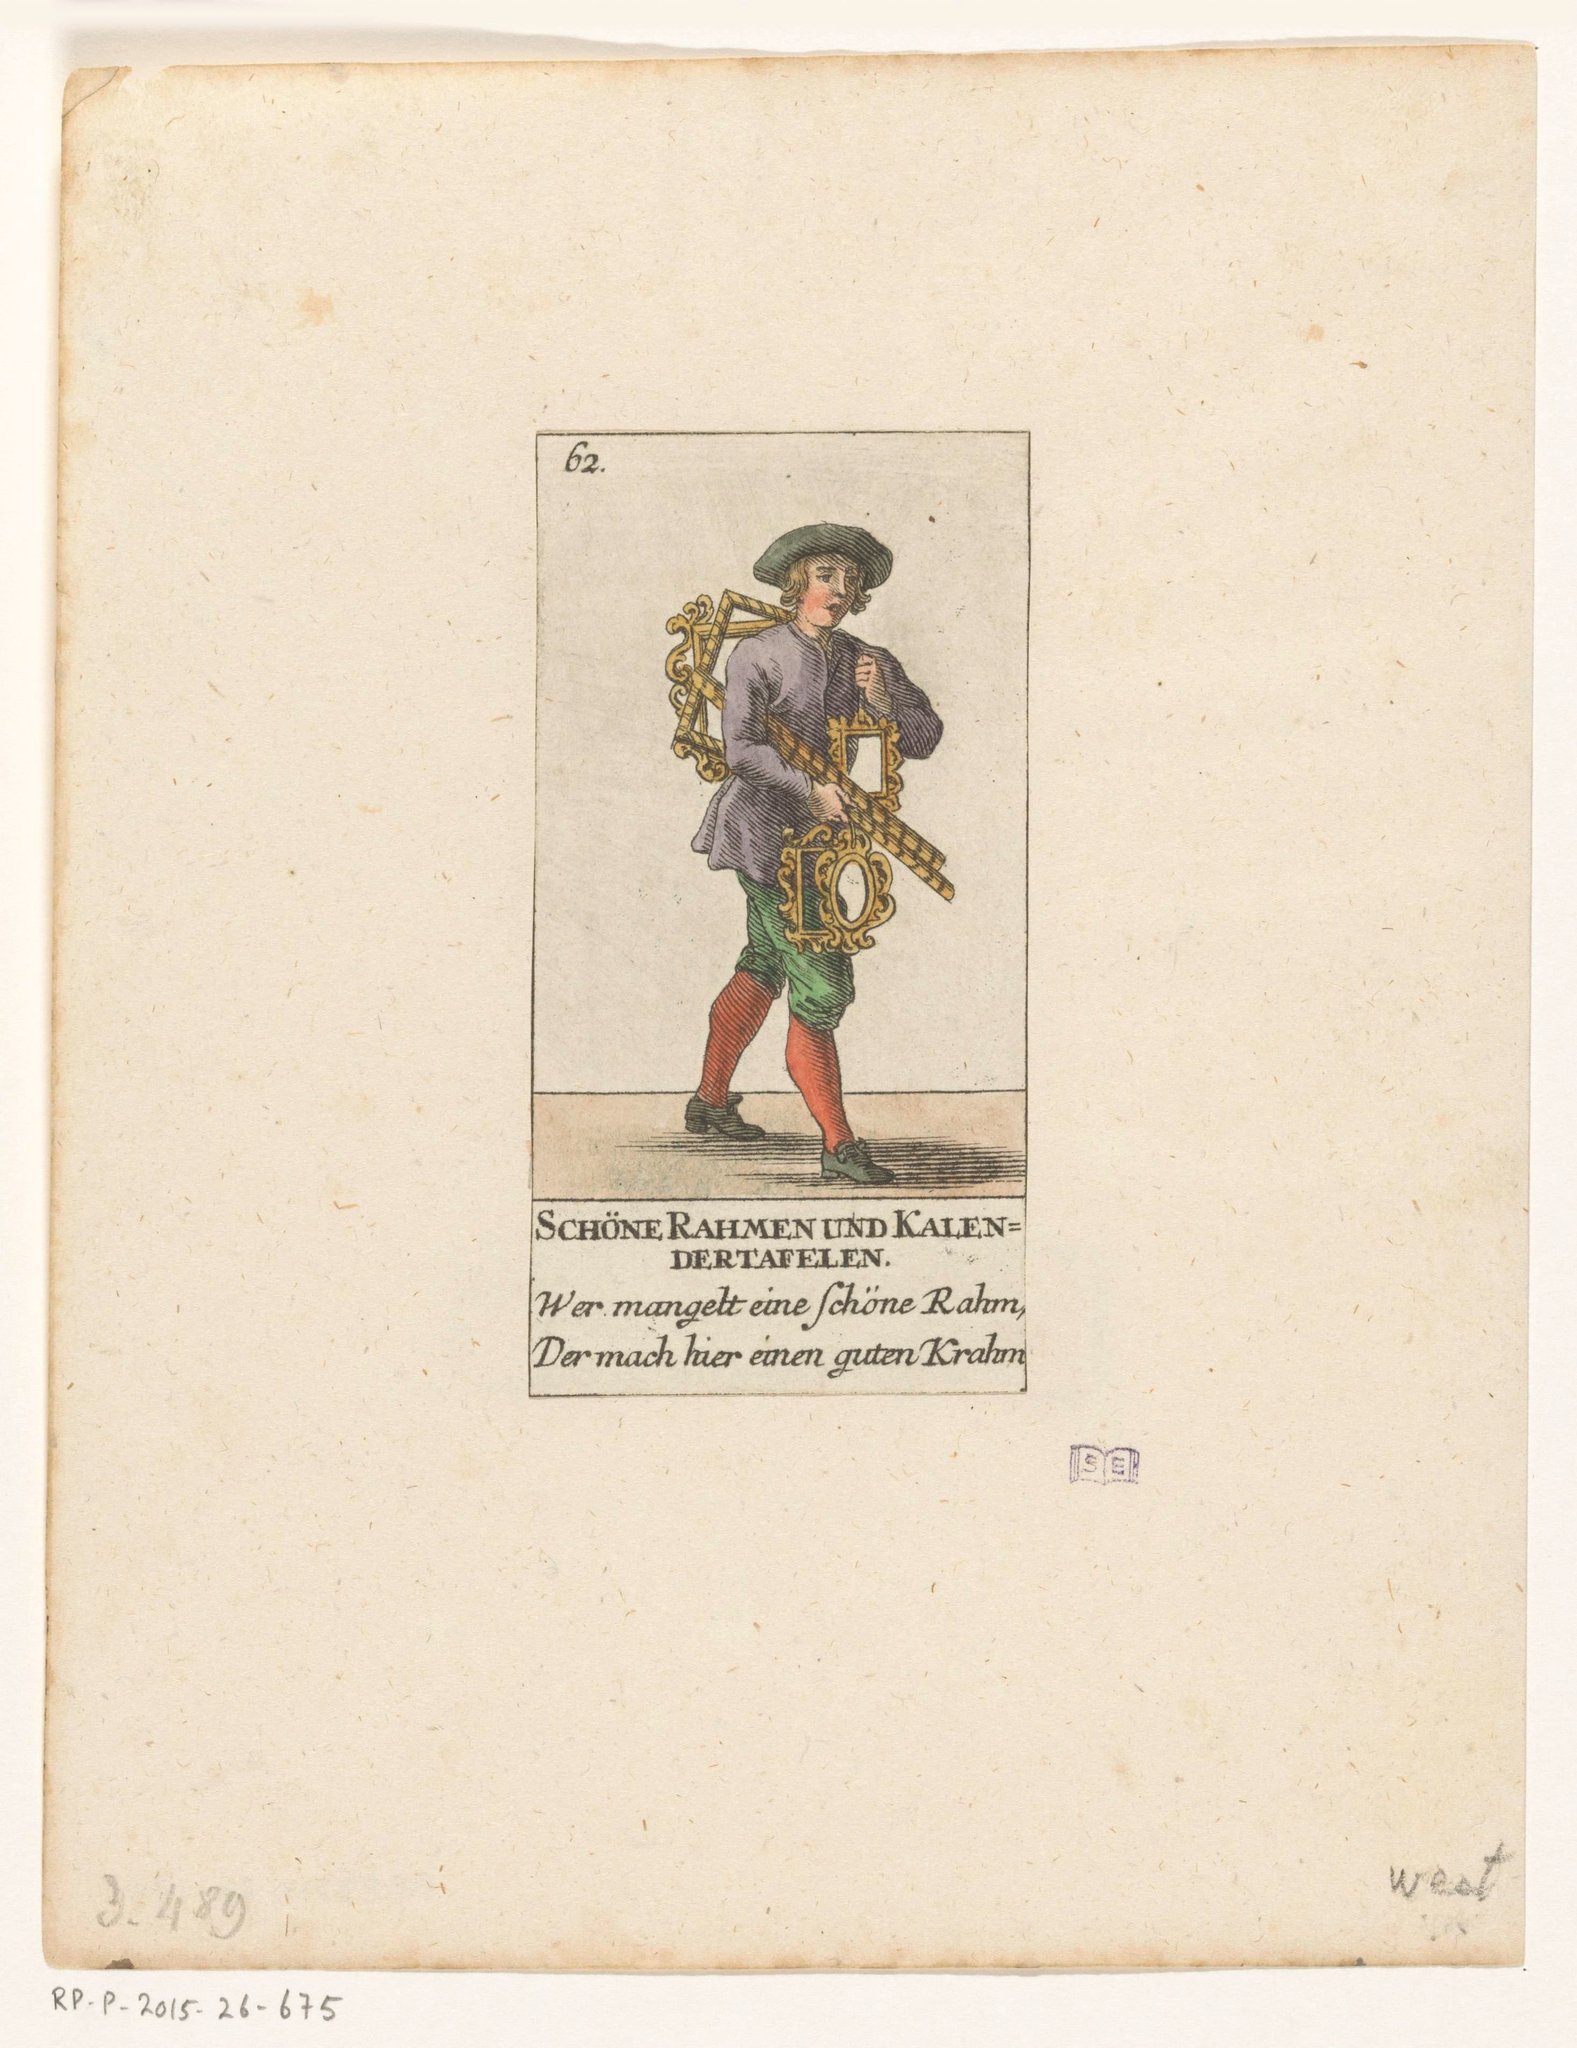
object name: print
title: Verkoper van lijsten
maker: david herrliberger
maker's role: print maker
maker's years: 1697-1777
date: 1749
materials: paper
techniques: engraving, hand coloring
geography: zurich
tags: street-trader, frame of painting, etc.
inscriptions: collector's mark: Lugt 2228, collector's mark: Lugt 4780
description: Fragment van blad 8 uit de serie: Zürcherische Ausruff-Bilder. Zweite Abtheilung. Zürich, David Herrliberger, 1749. David Herrliberger gaf de eerste serie, bestaande uit 52 figuren, uit in 1748. In 1749 en 1751 volgden vervolgseries van elk 52 prenten.